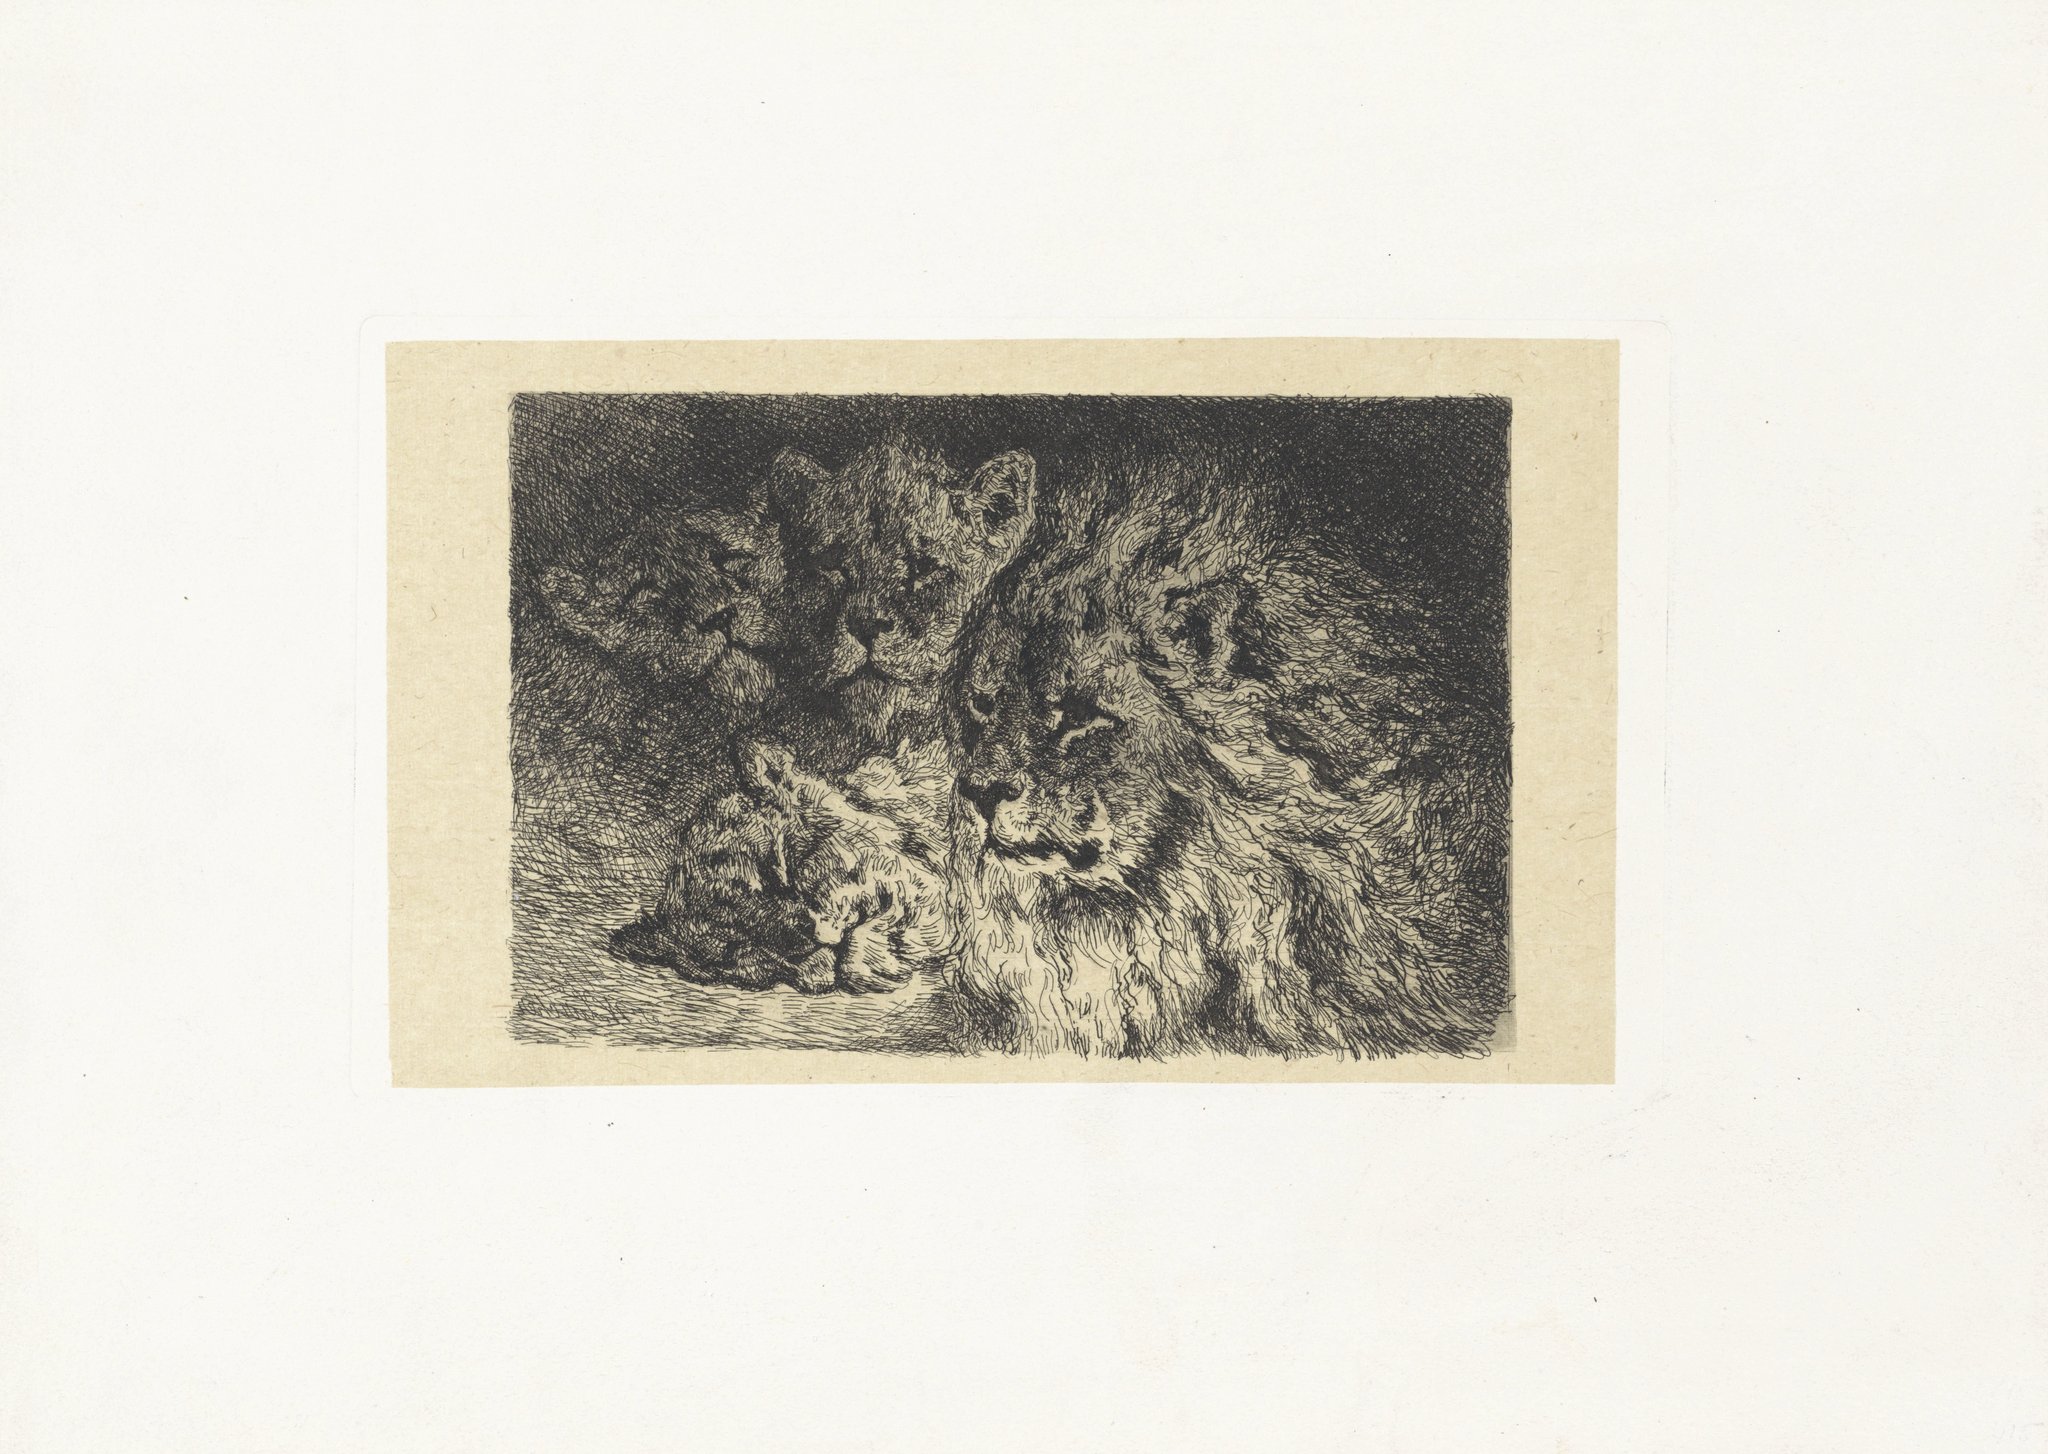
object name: print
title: Leeuw en leeuwinnen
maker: frederik willem zürcher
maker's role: draughtsman, print maker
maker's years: 1835-1894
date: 1845-1894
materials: paper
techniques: etching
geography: amsterdam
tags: beasts of prey, predatory animals: lion (+ female animal), beasts of prey, predatory animals: lion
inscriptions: collector's mark: Lugt 2228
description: De kop van een leeuw en links drie leeuwinnen.